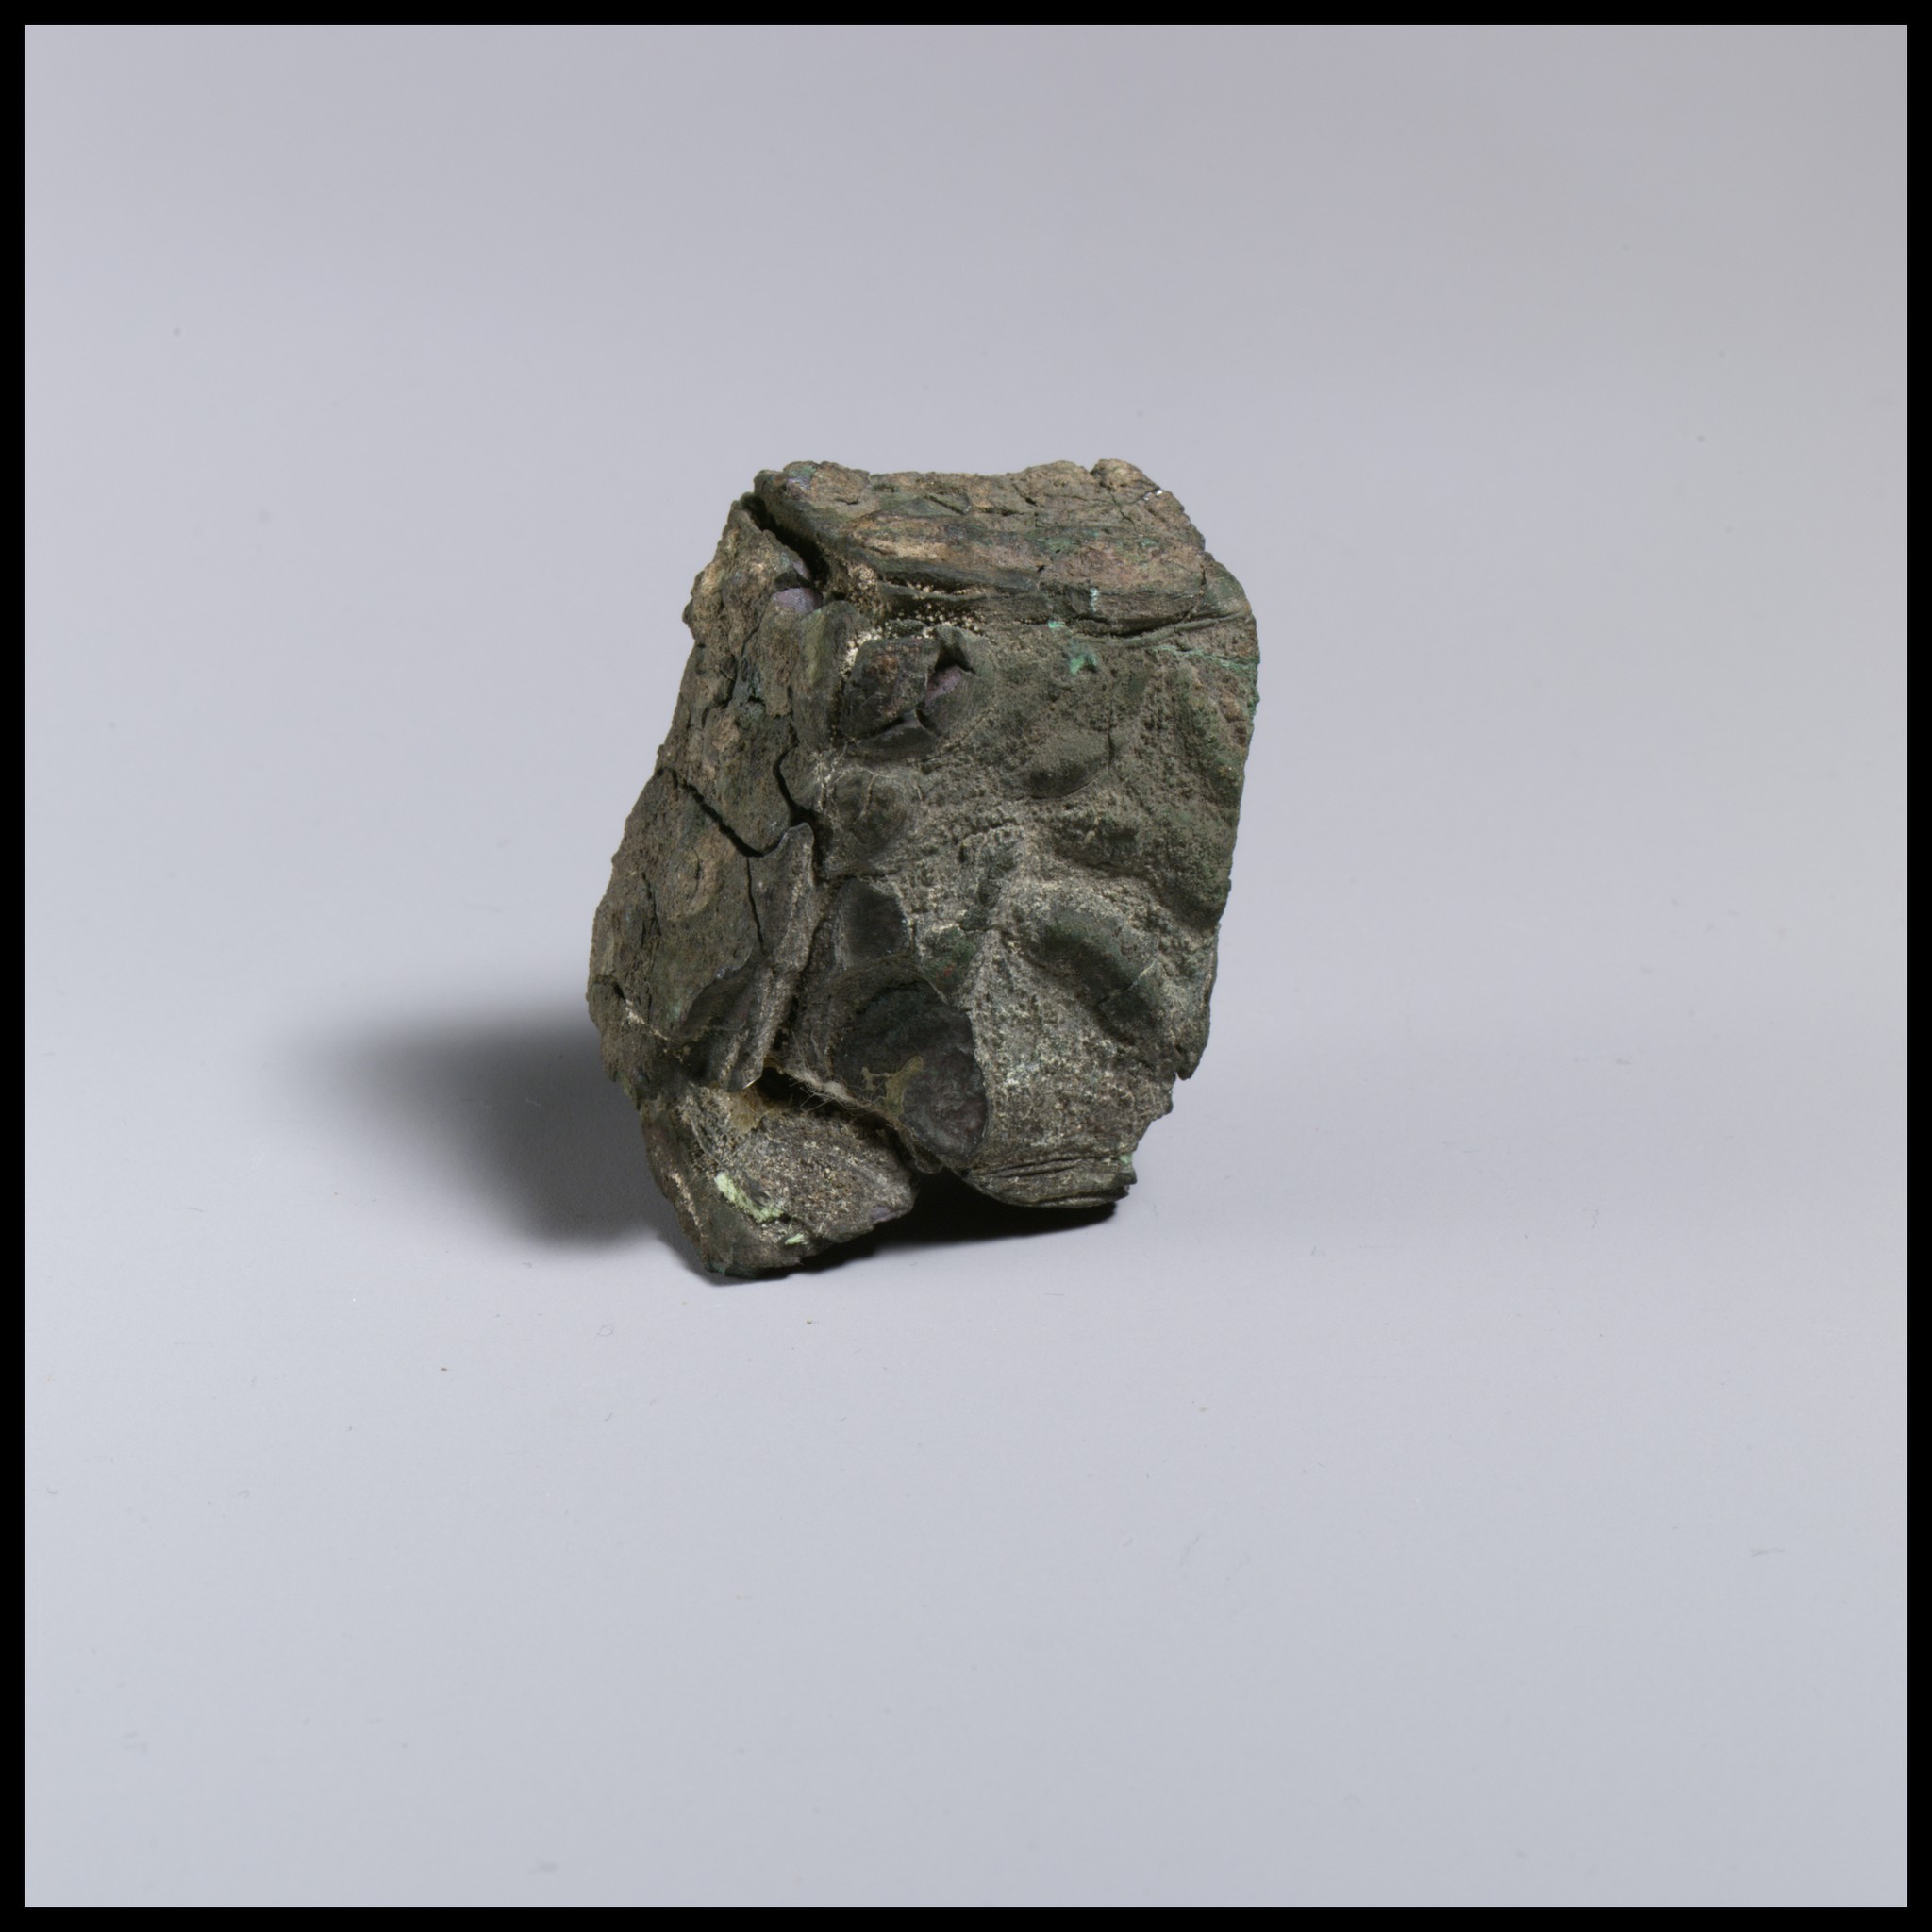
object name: block of bronze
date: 7000 BCE-330 CE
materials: bronze